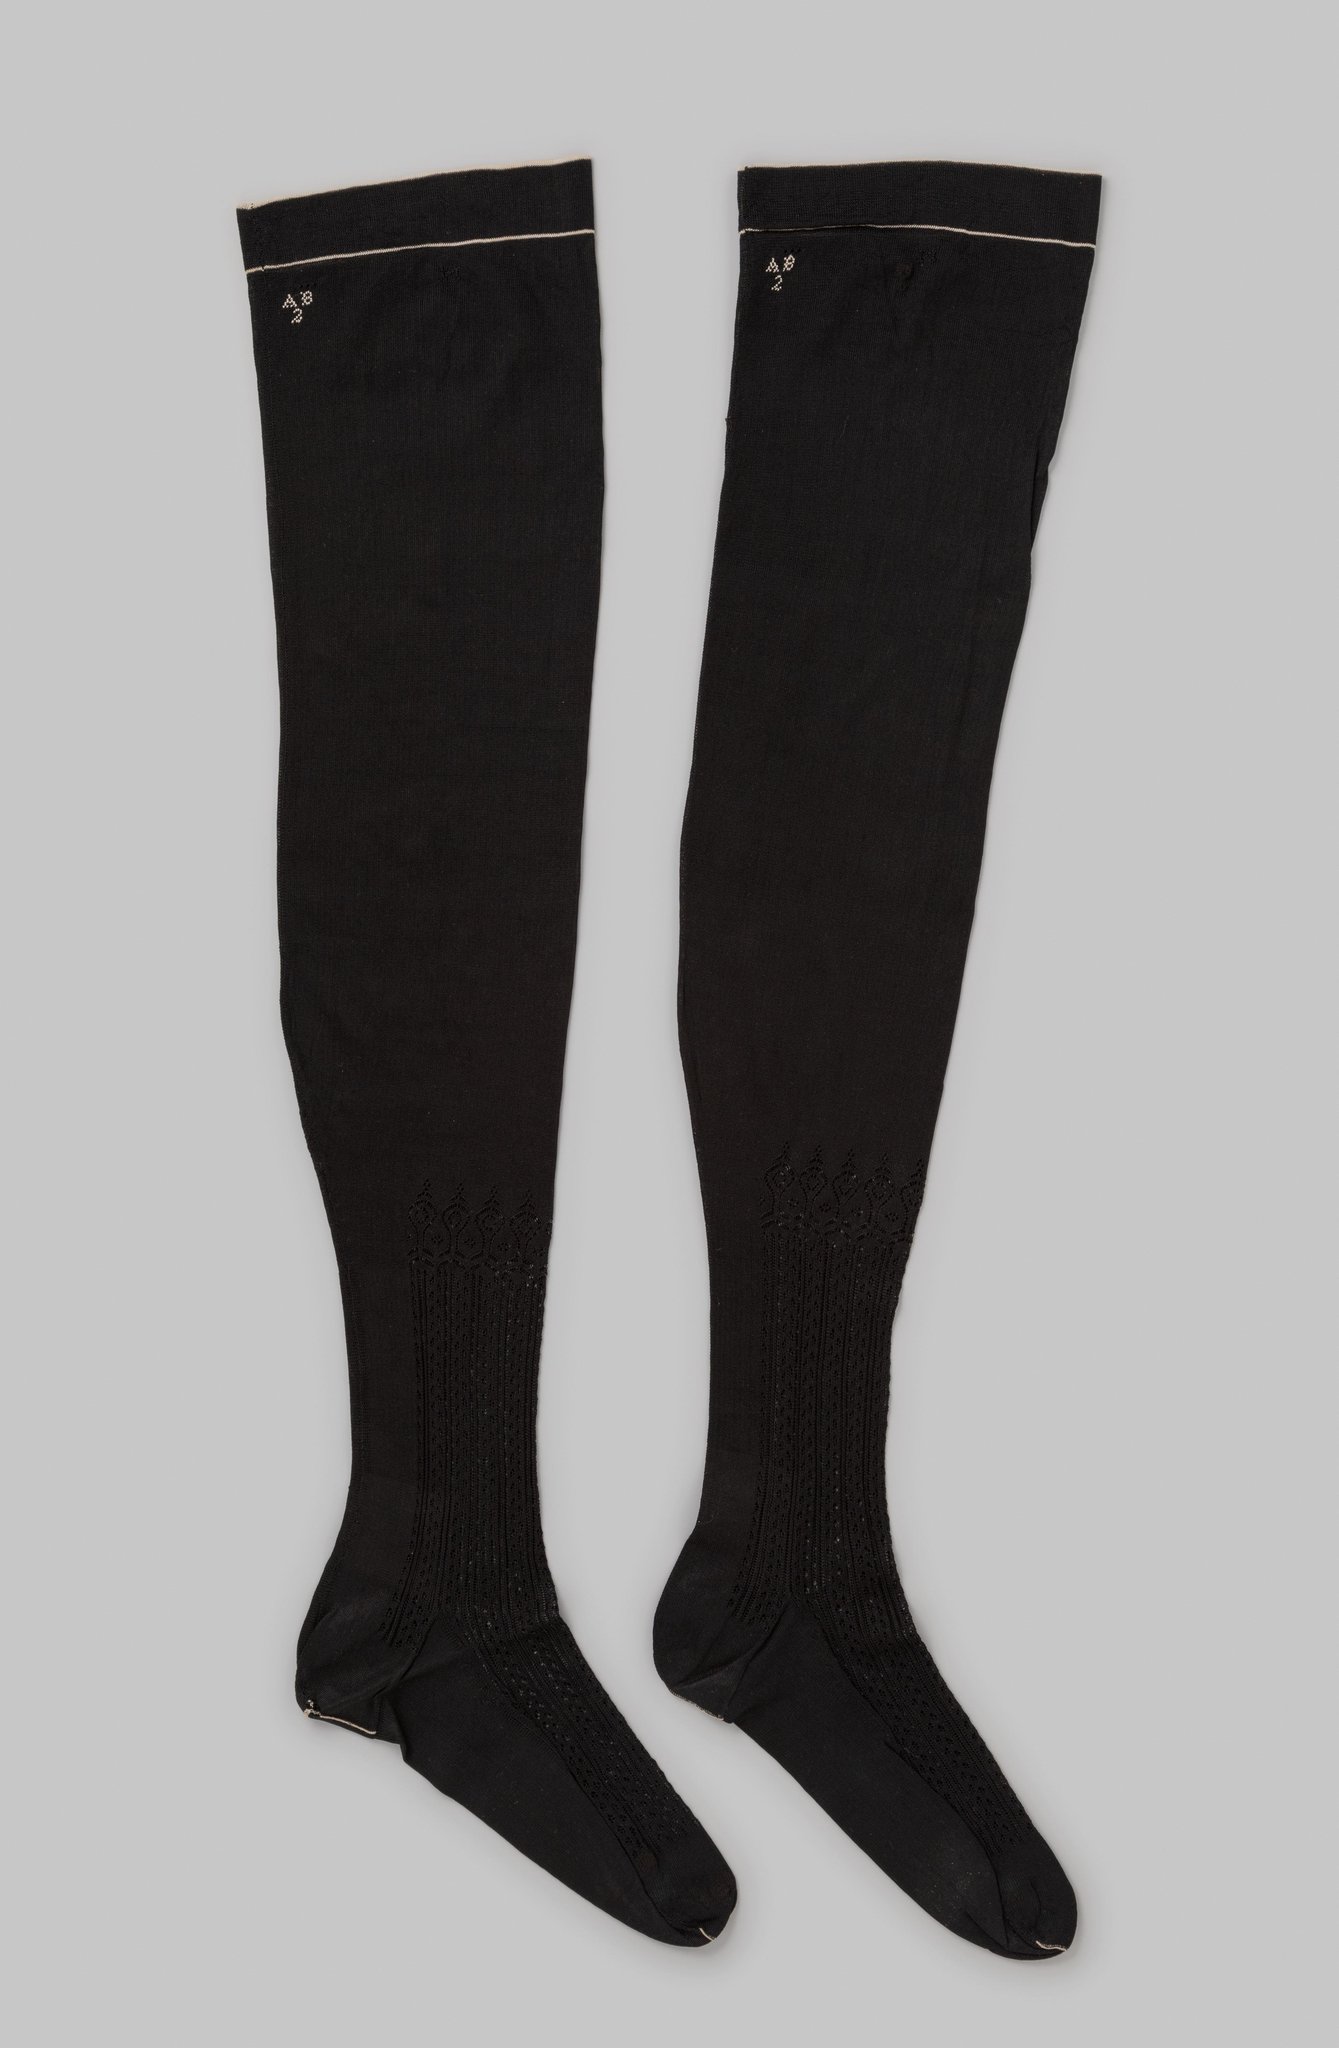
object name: stocking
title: Kous van zwarte zijde, opengewerkte klinken en wreef, dubbele boord afgezet met wit randje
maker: Anonymous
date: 1900-1925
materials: silk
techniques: embroidered, knitting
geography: canada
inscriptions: initials: ‘M’, initials: ‘AB 2’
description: Paar kousen van zwarte zijde. Opengewerkte klinken en wreef met geometrische ajour versiering. Dubbele boord afgezet met wit randje. Naad middenachter. Met witte zijde gemerkt in kruissteek: AB 2.